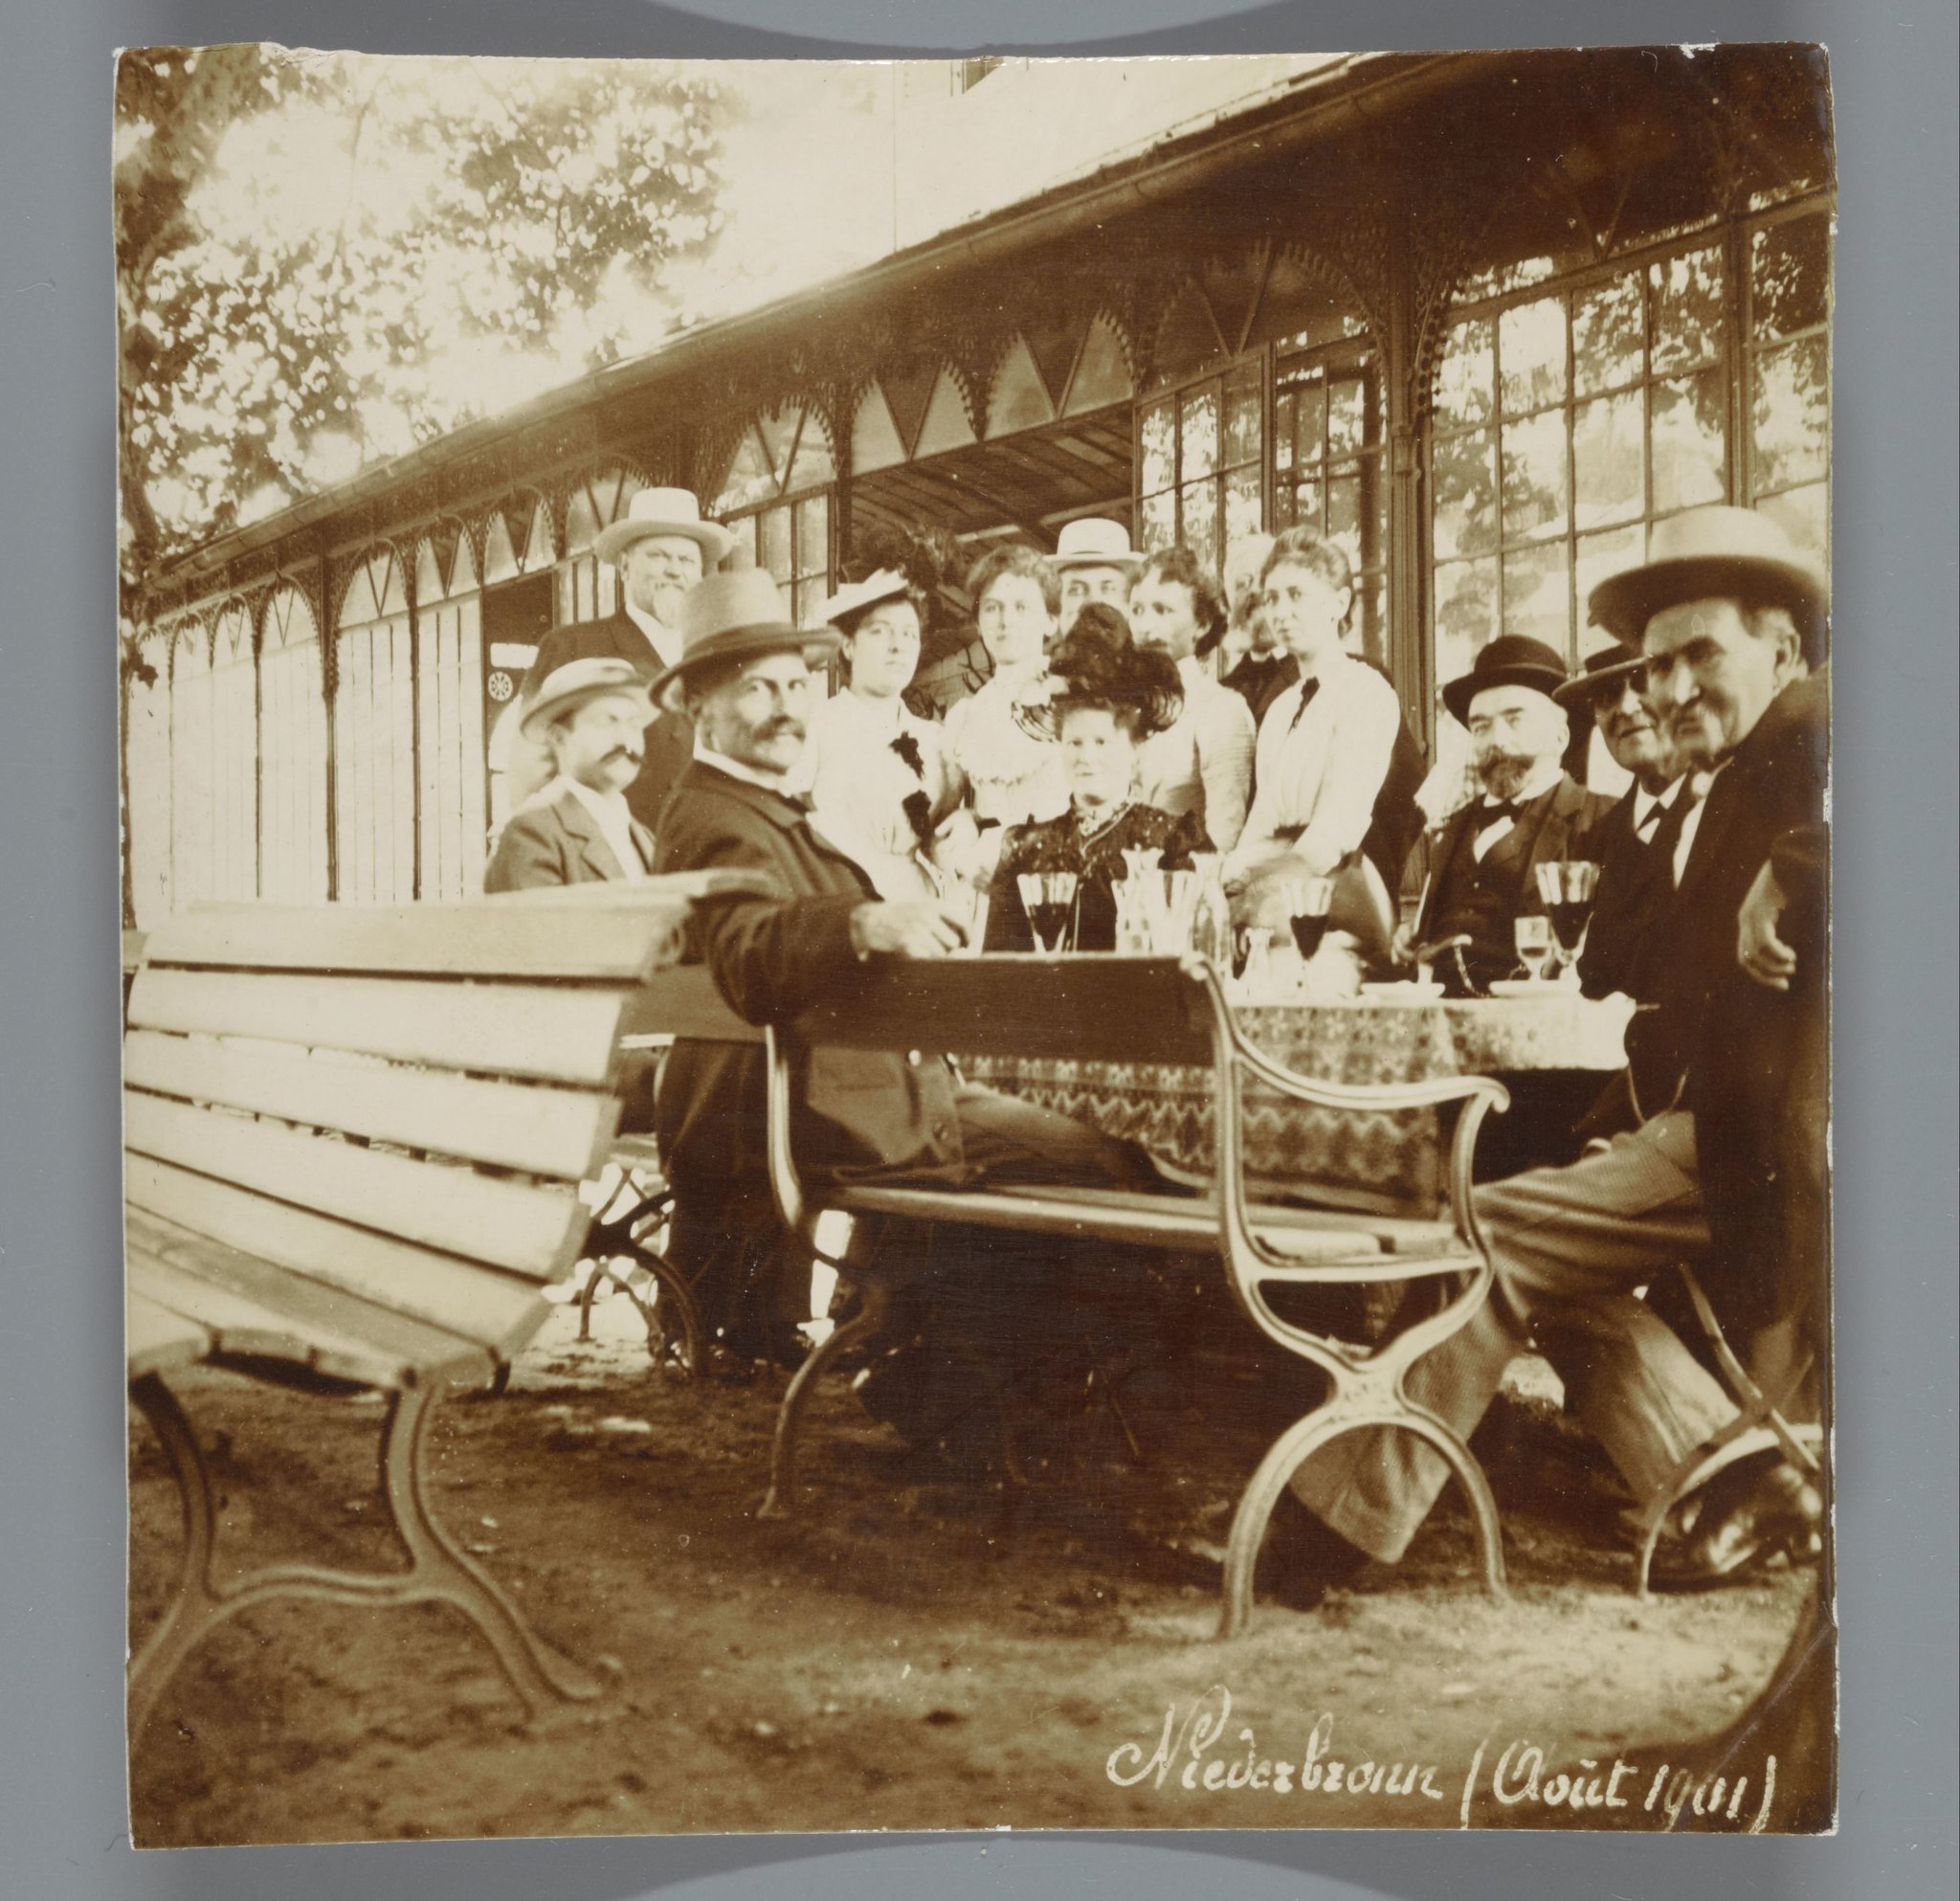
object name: photograph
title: Gezelschap aan een tafel, Niederbronn (Bas-Rhin, Elzas), Frankrijk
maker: Anonymous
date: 1901-1908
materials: paper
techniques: gelatin silver print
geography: france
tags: (family) meal - cc - out of doors, france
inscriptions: annotation: ‘Niederbronn (Août 1901)’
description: Gezelschap aan een tafel, Niederbronn (Bas-Rhin, Elzas), Frankrijk.